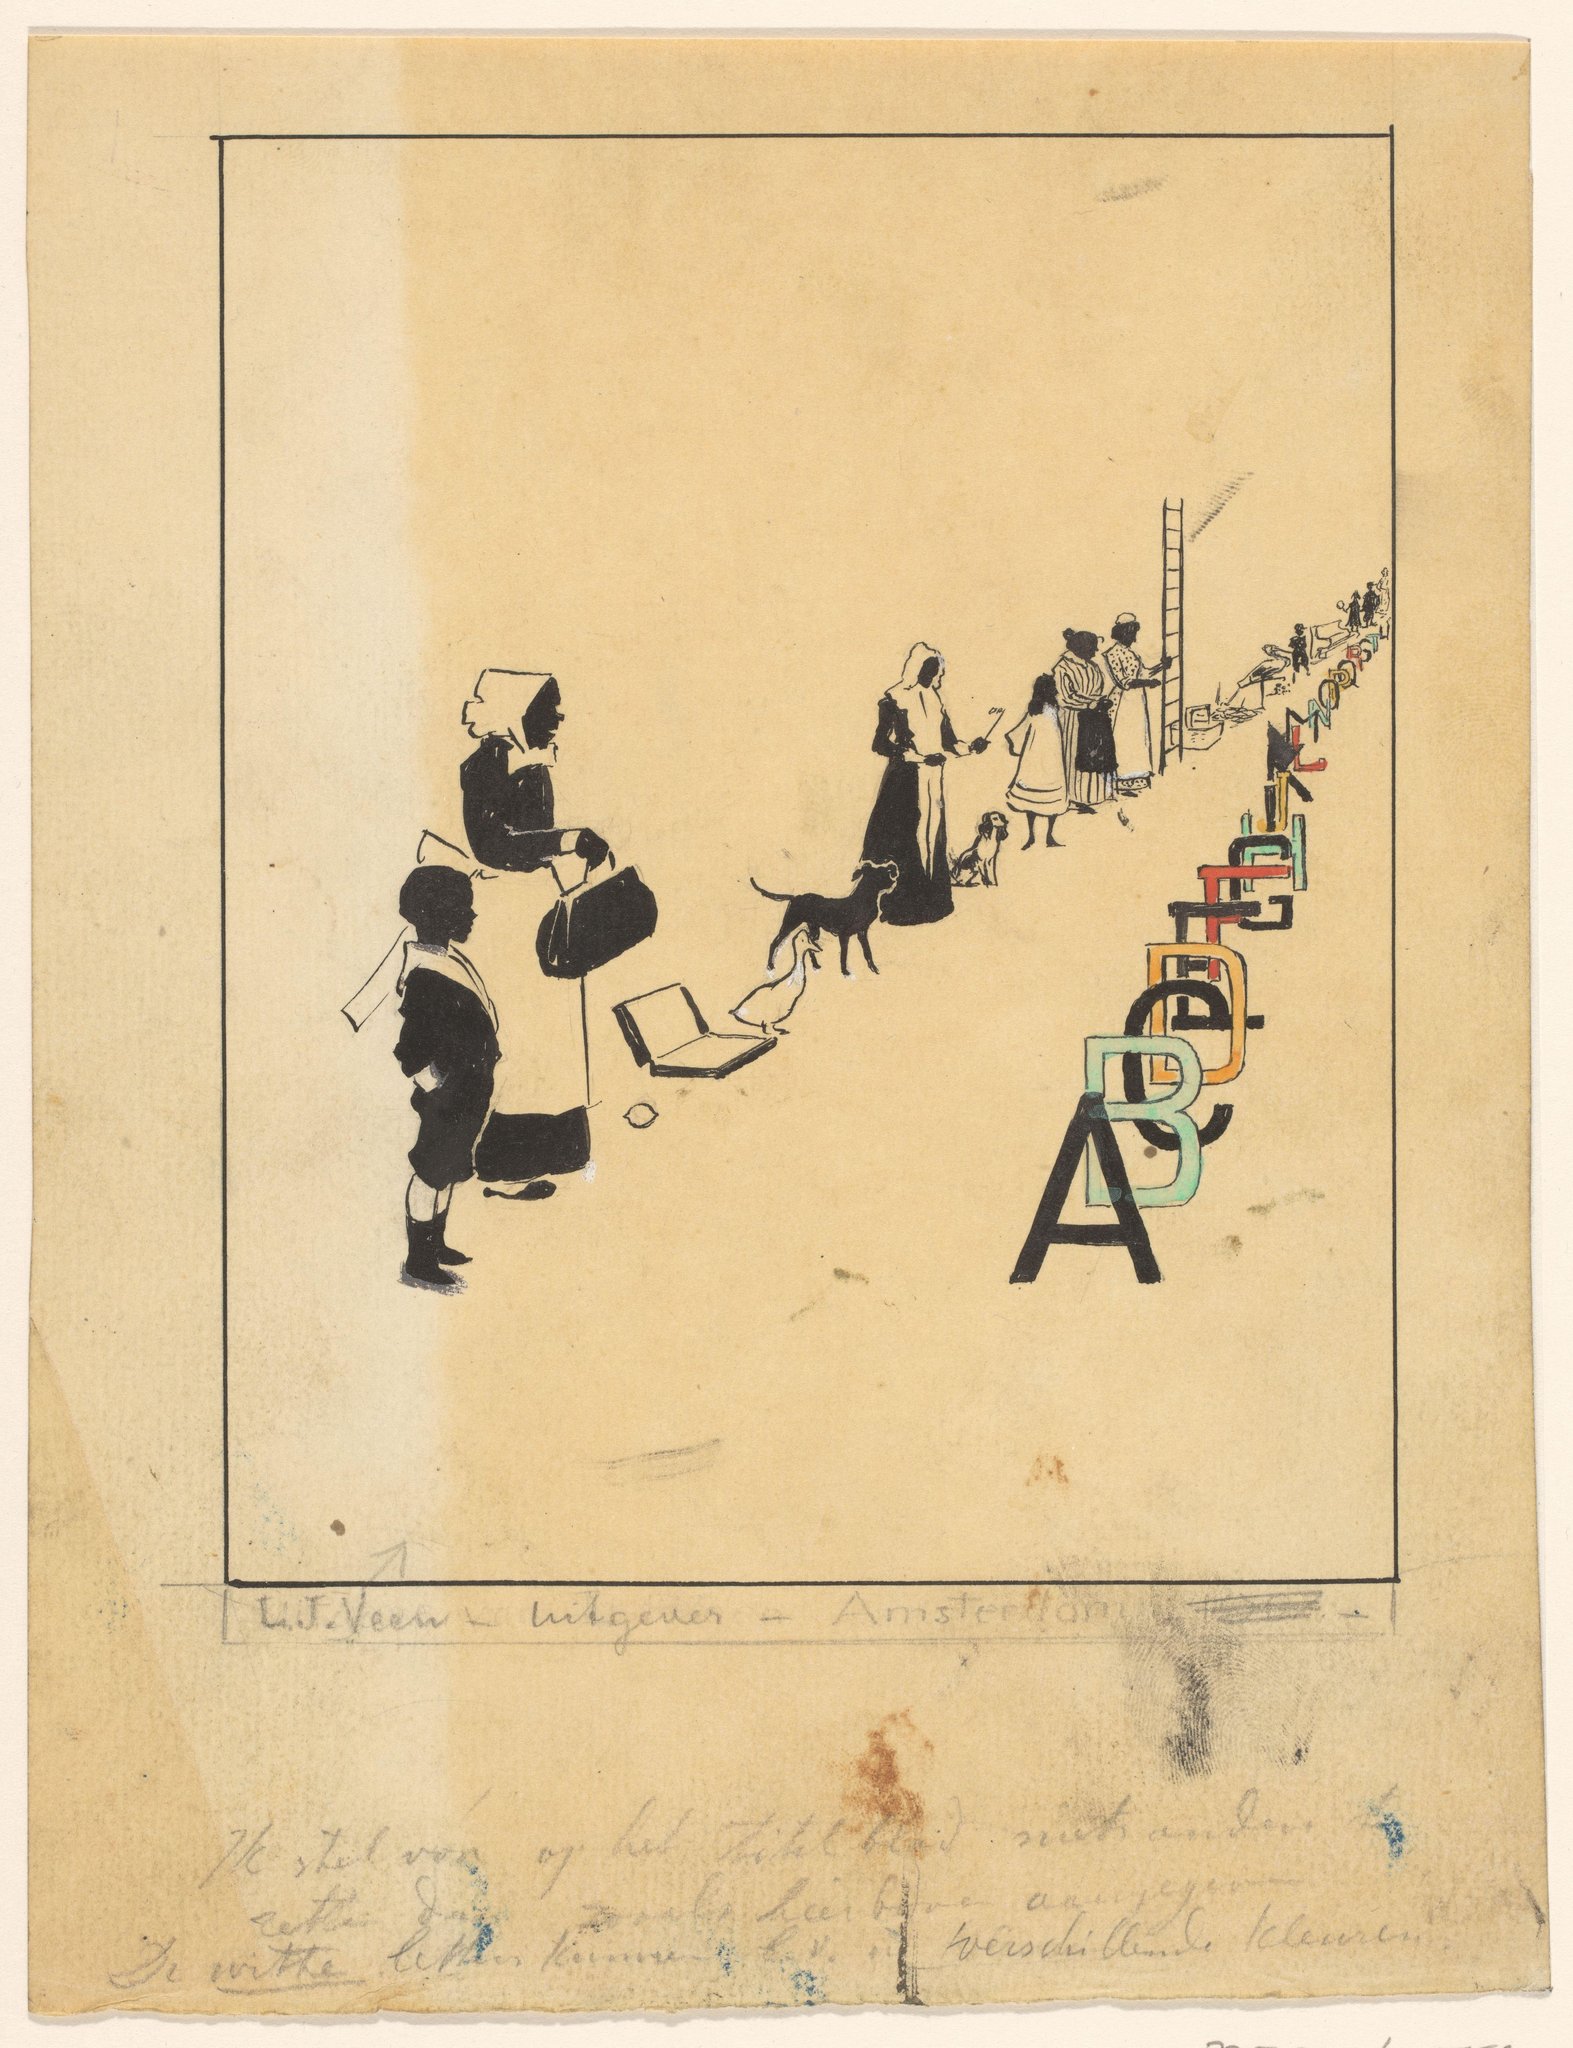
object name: drawing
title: Rijen met letters van het alfabet, mensen, dieren en voorwerpen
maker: Anonymous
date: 1880-1910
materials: paint, ink, paper, pencil, watercolor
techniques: brush, pen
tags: human life and its ages (young, adult, old, etc.), animals, letters, alphabet, script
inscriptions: collector's mark: Lugt 2228a, :